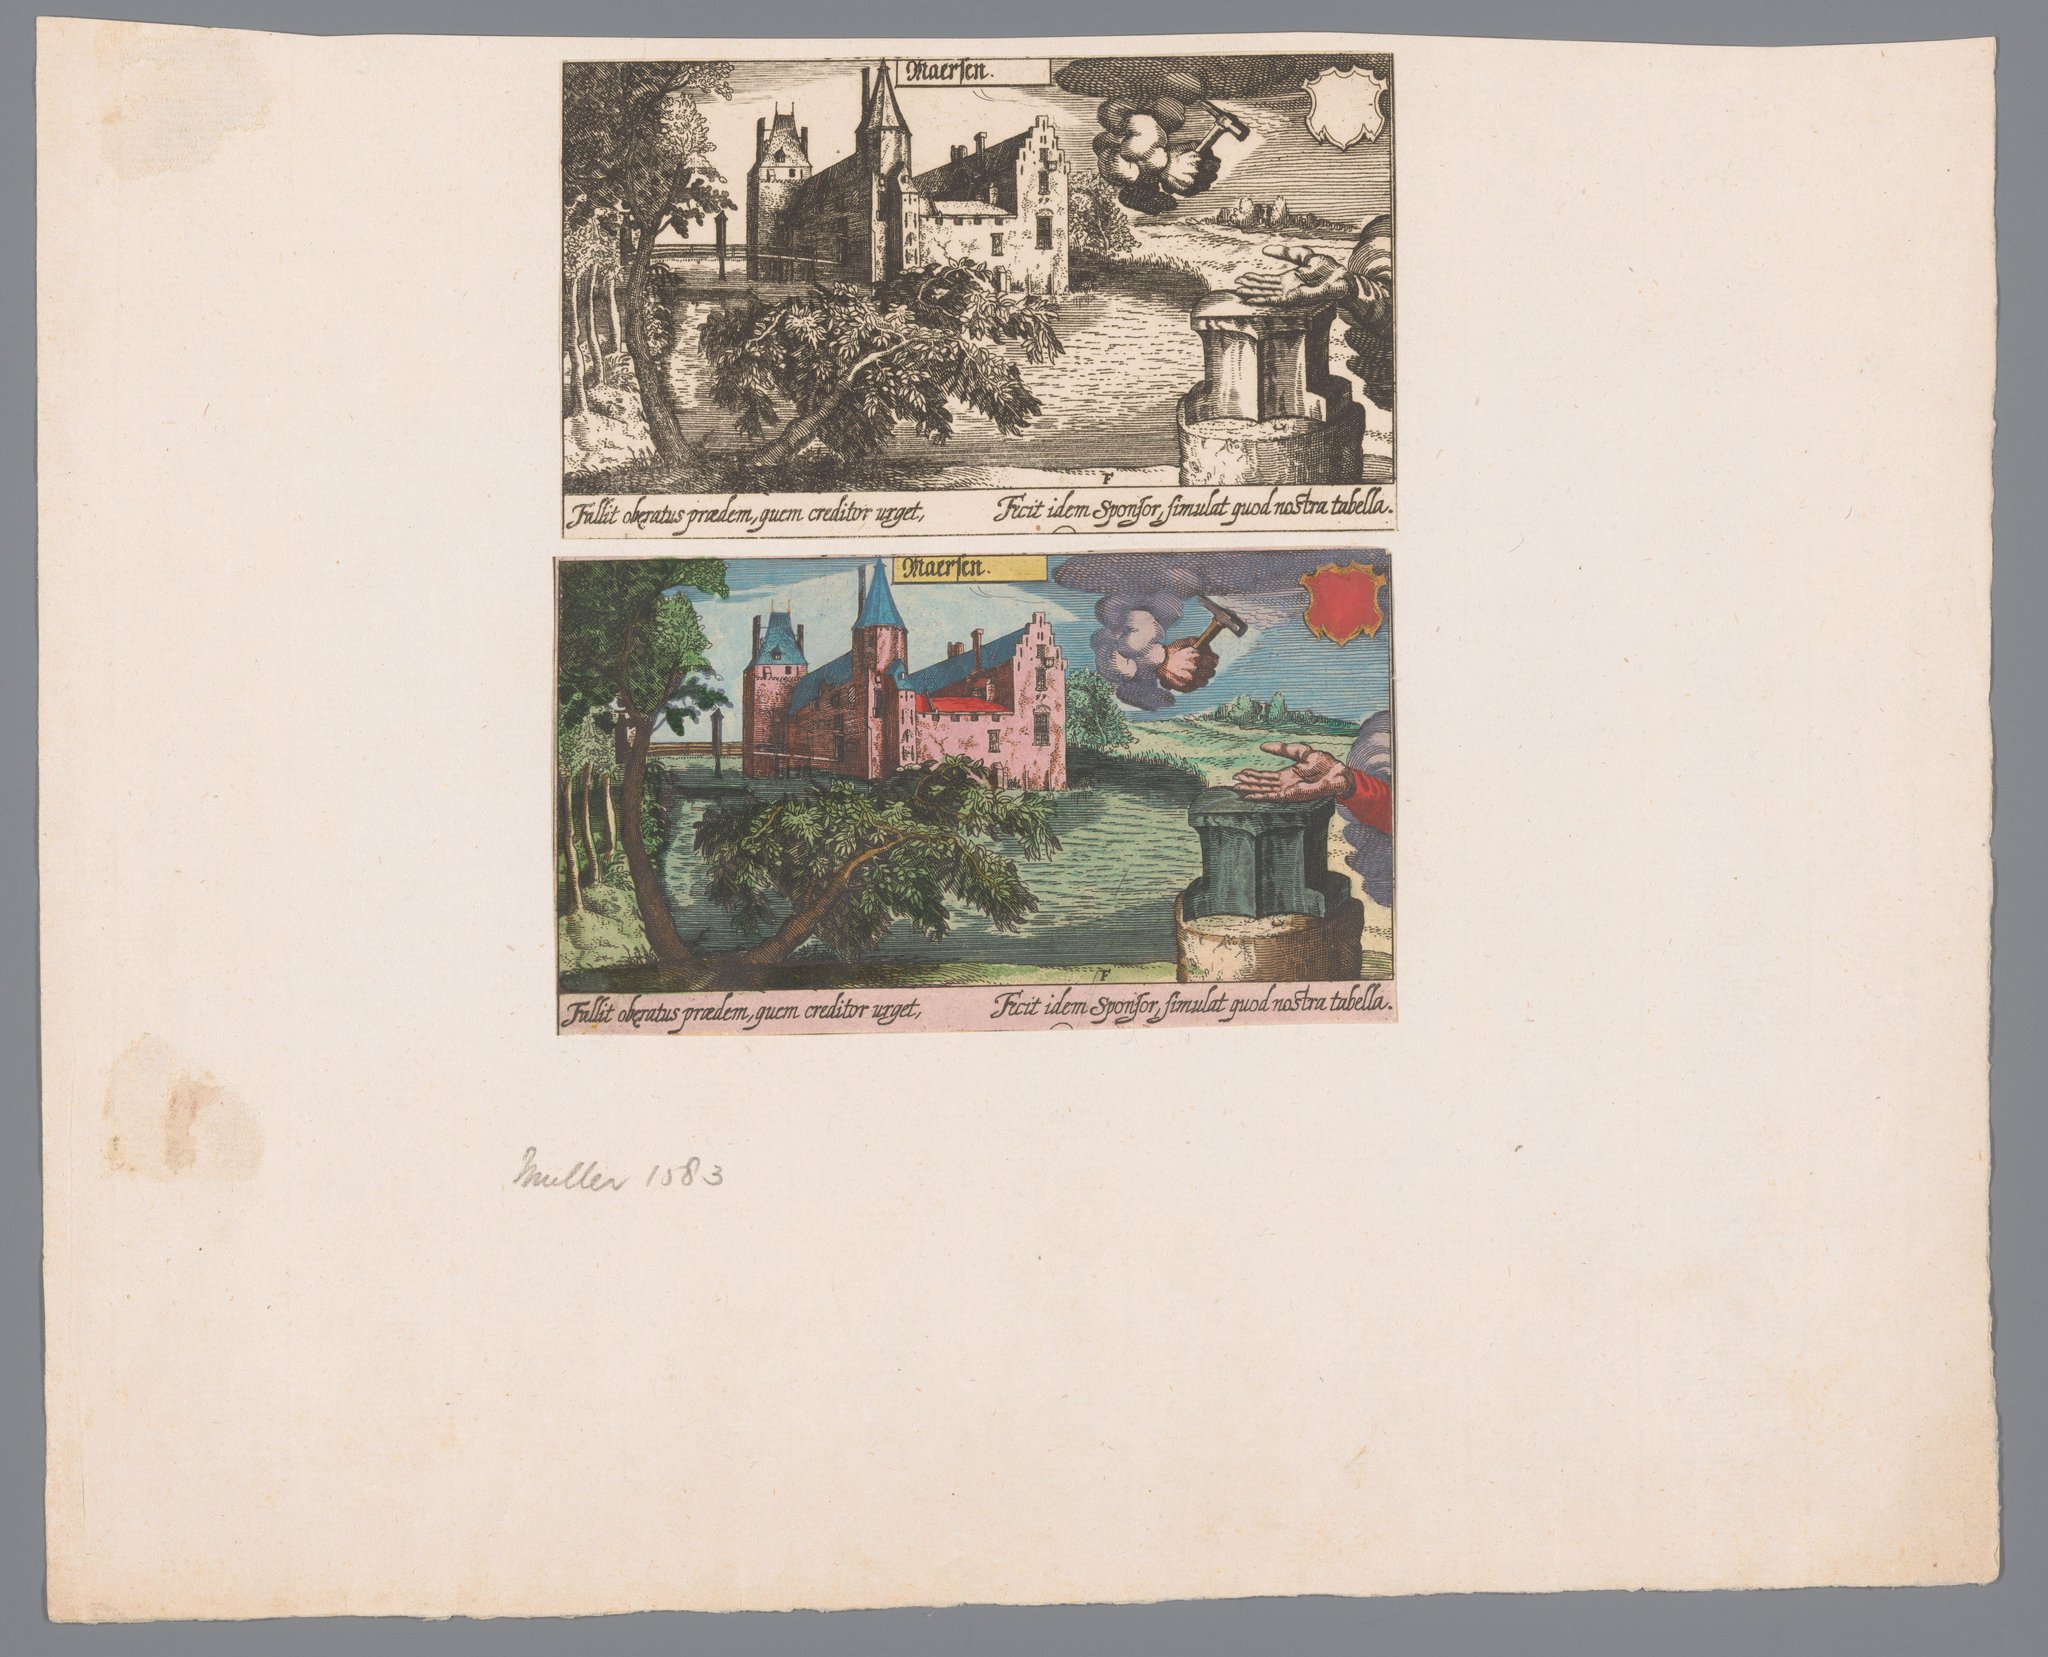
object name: print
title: Gezicht op Huis Ter Meer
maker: Anonymous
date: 1700-1750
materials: paper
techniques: engraving, etching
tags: castle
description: Twee dezelfde prenten van Huis Ter Meer met rechts een hand op een aanbeeld en een hand met hamer. De onderste afbeelding is ingekleurd.